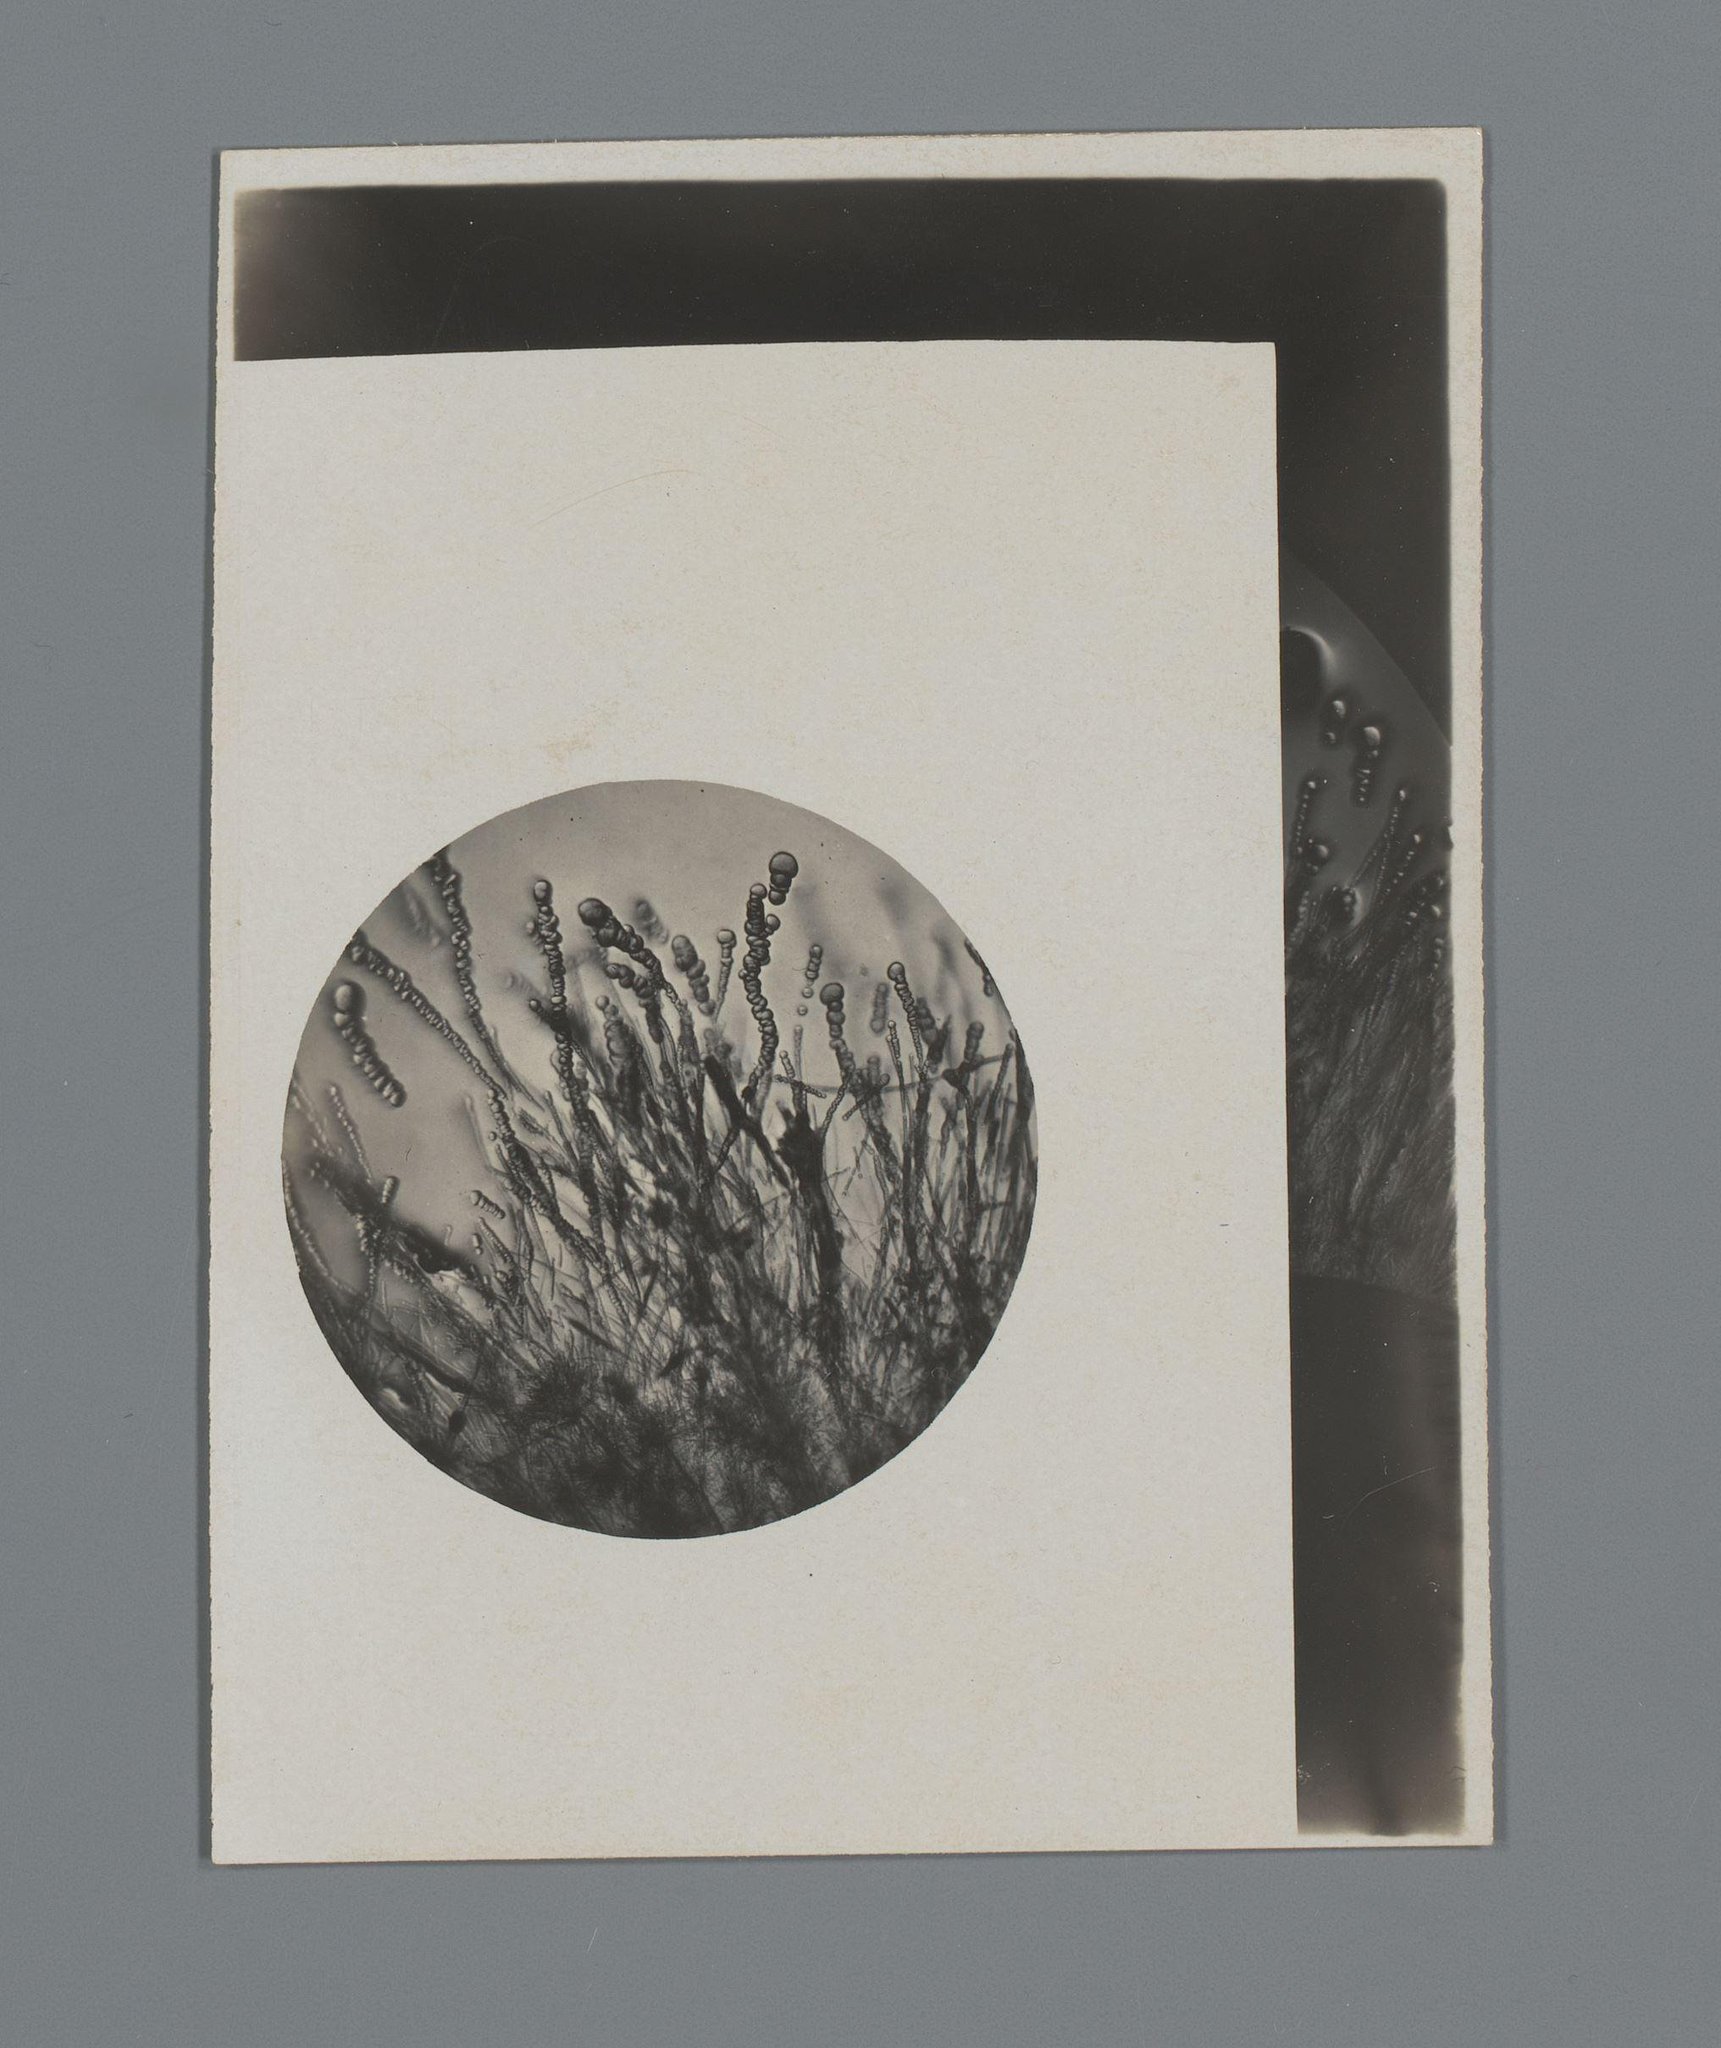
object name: photograph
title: Opname van een microscopisch preparaat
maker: Anonymous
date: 1880-1910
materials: paper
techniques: gelatin silver print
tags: unicellular animals, bacteria, bacilli